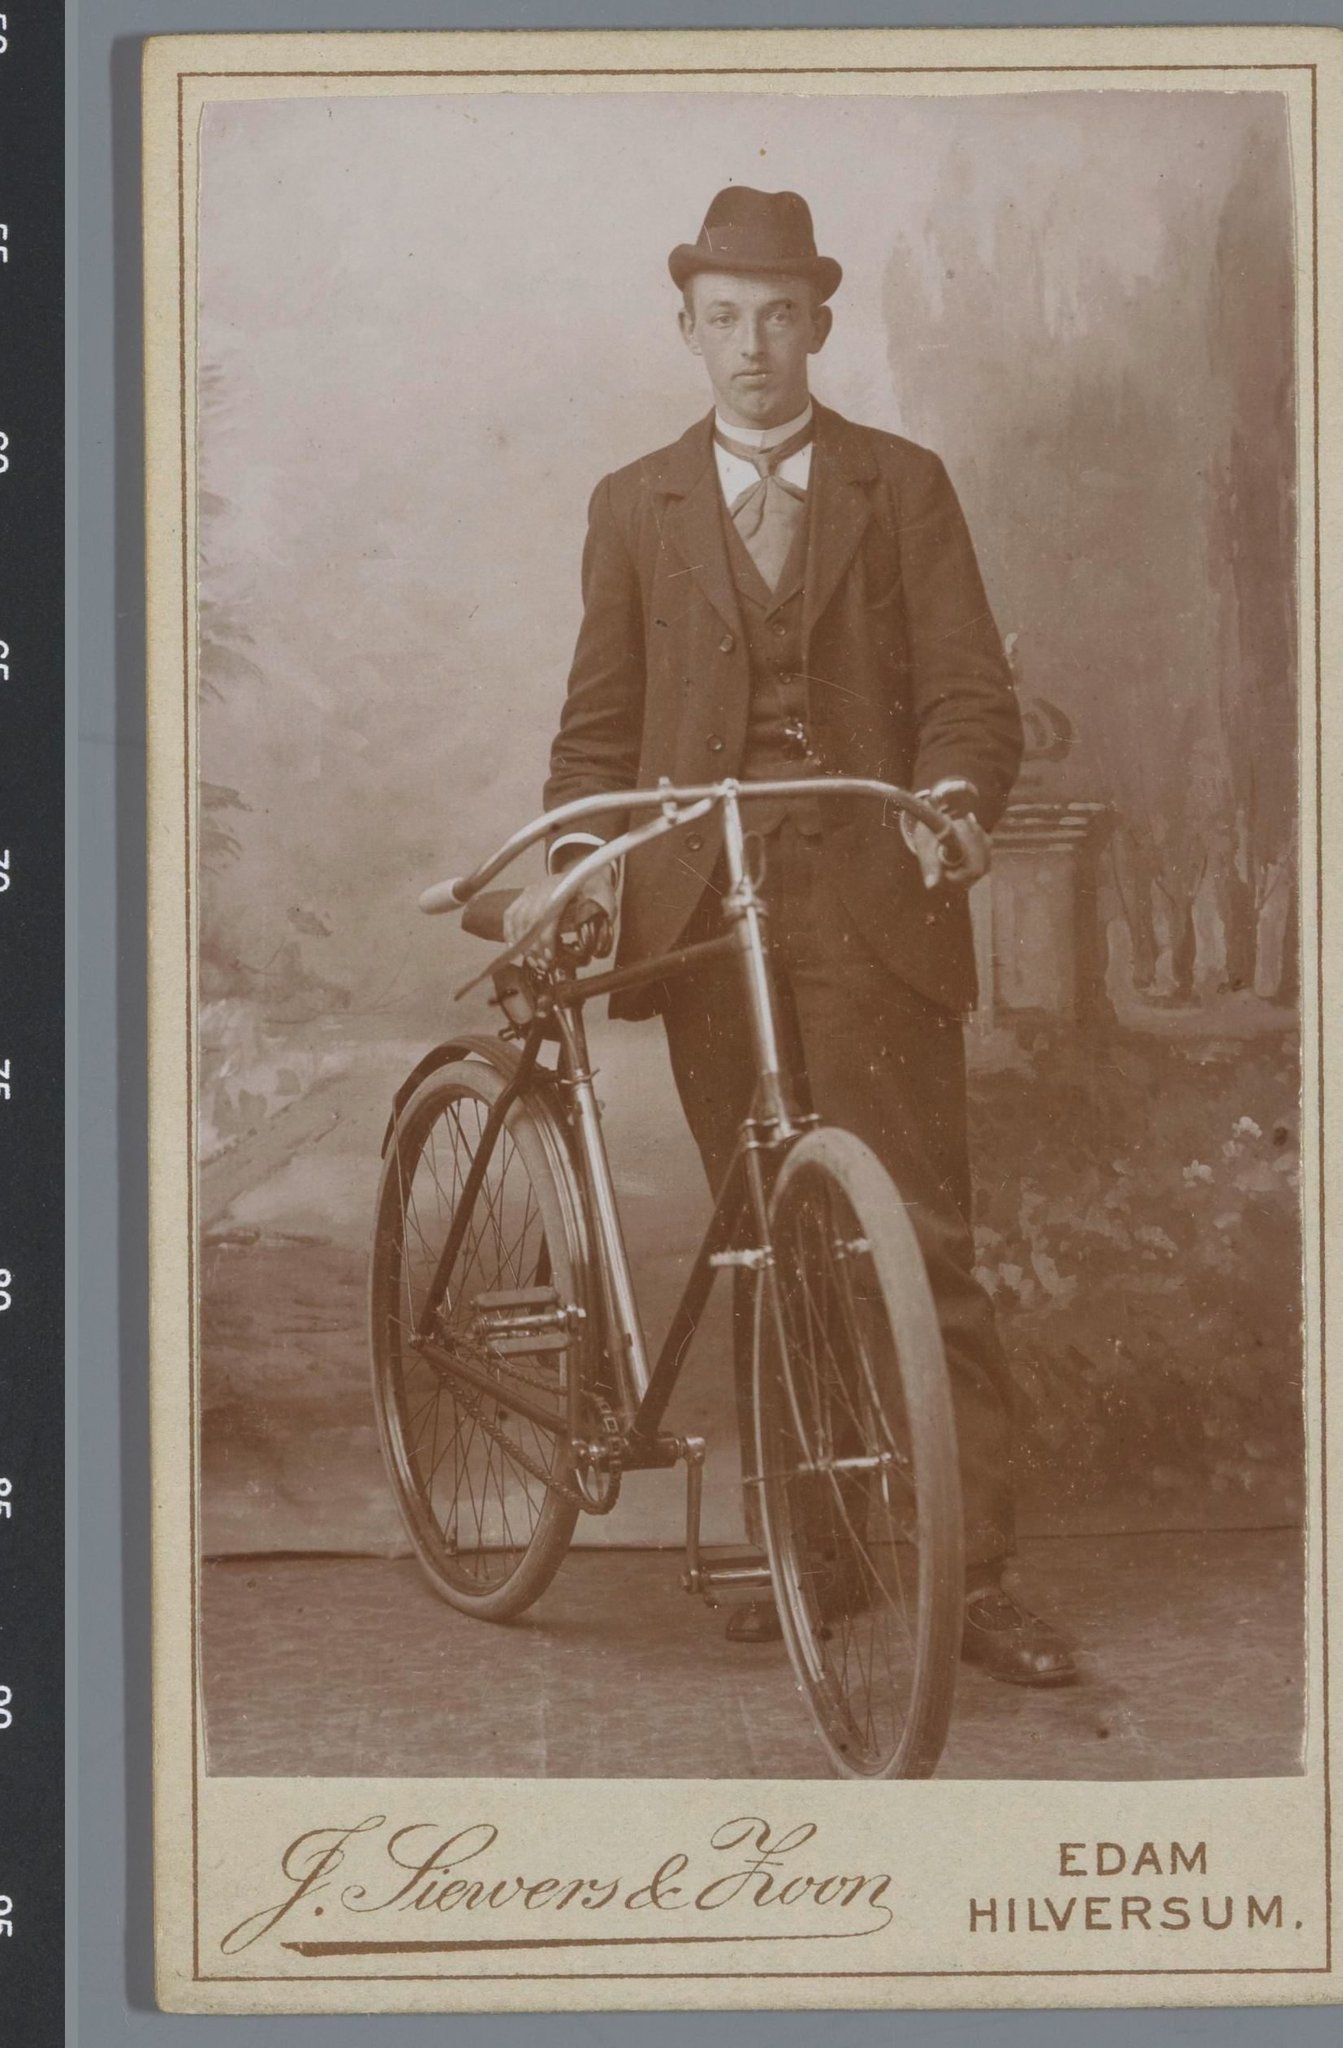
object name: photograph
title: Portret van Cornelis Meereboer met een fiets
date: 1890-1918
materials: cardboard, photographic support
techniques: collodion silver print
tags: adult man, historical persons, bicycle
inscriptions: inscription: ‘Photographische/ ATELIERS/ J. Siewers & Zoon/ EDAM/ HILVERSUM./ Specialiteit in vergrootingen.’